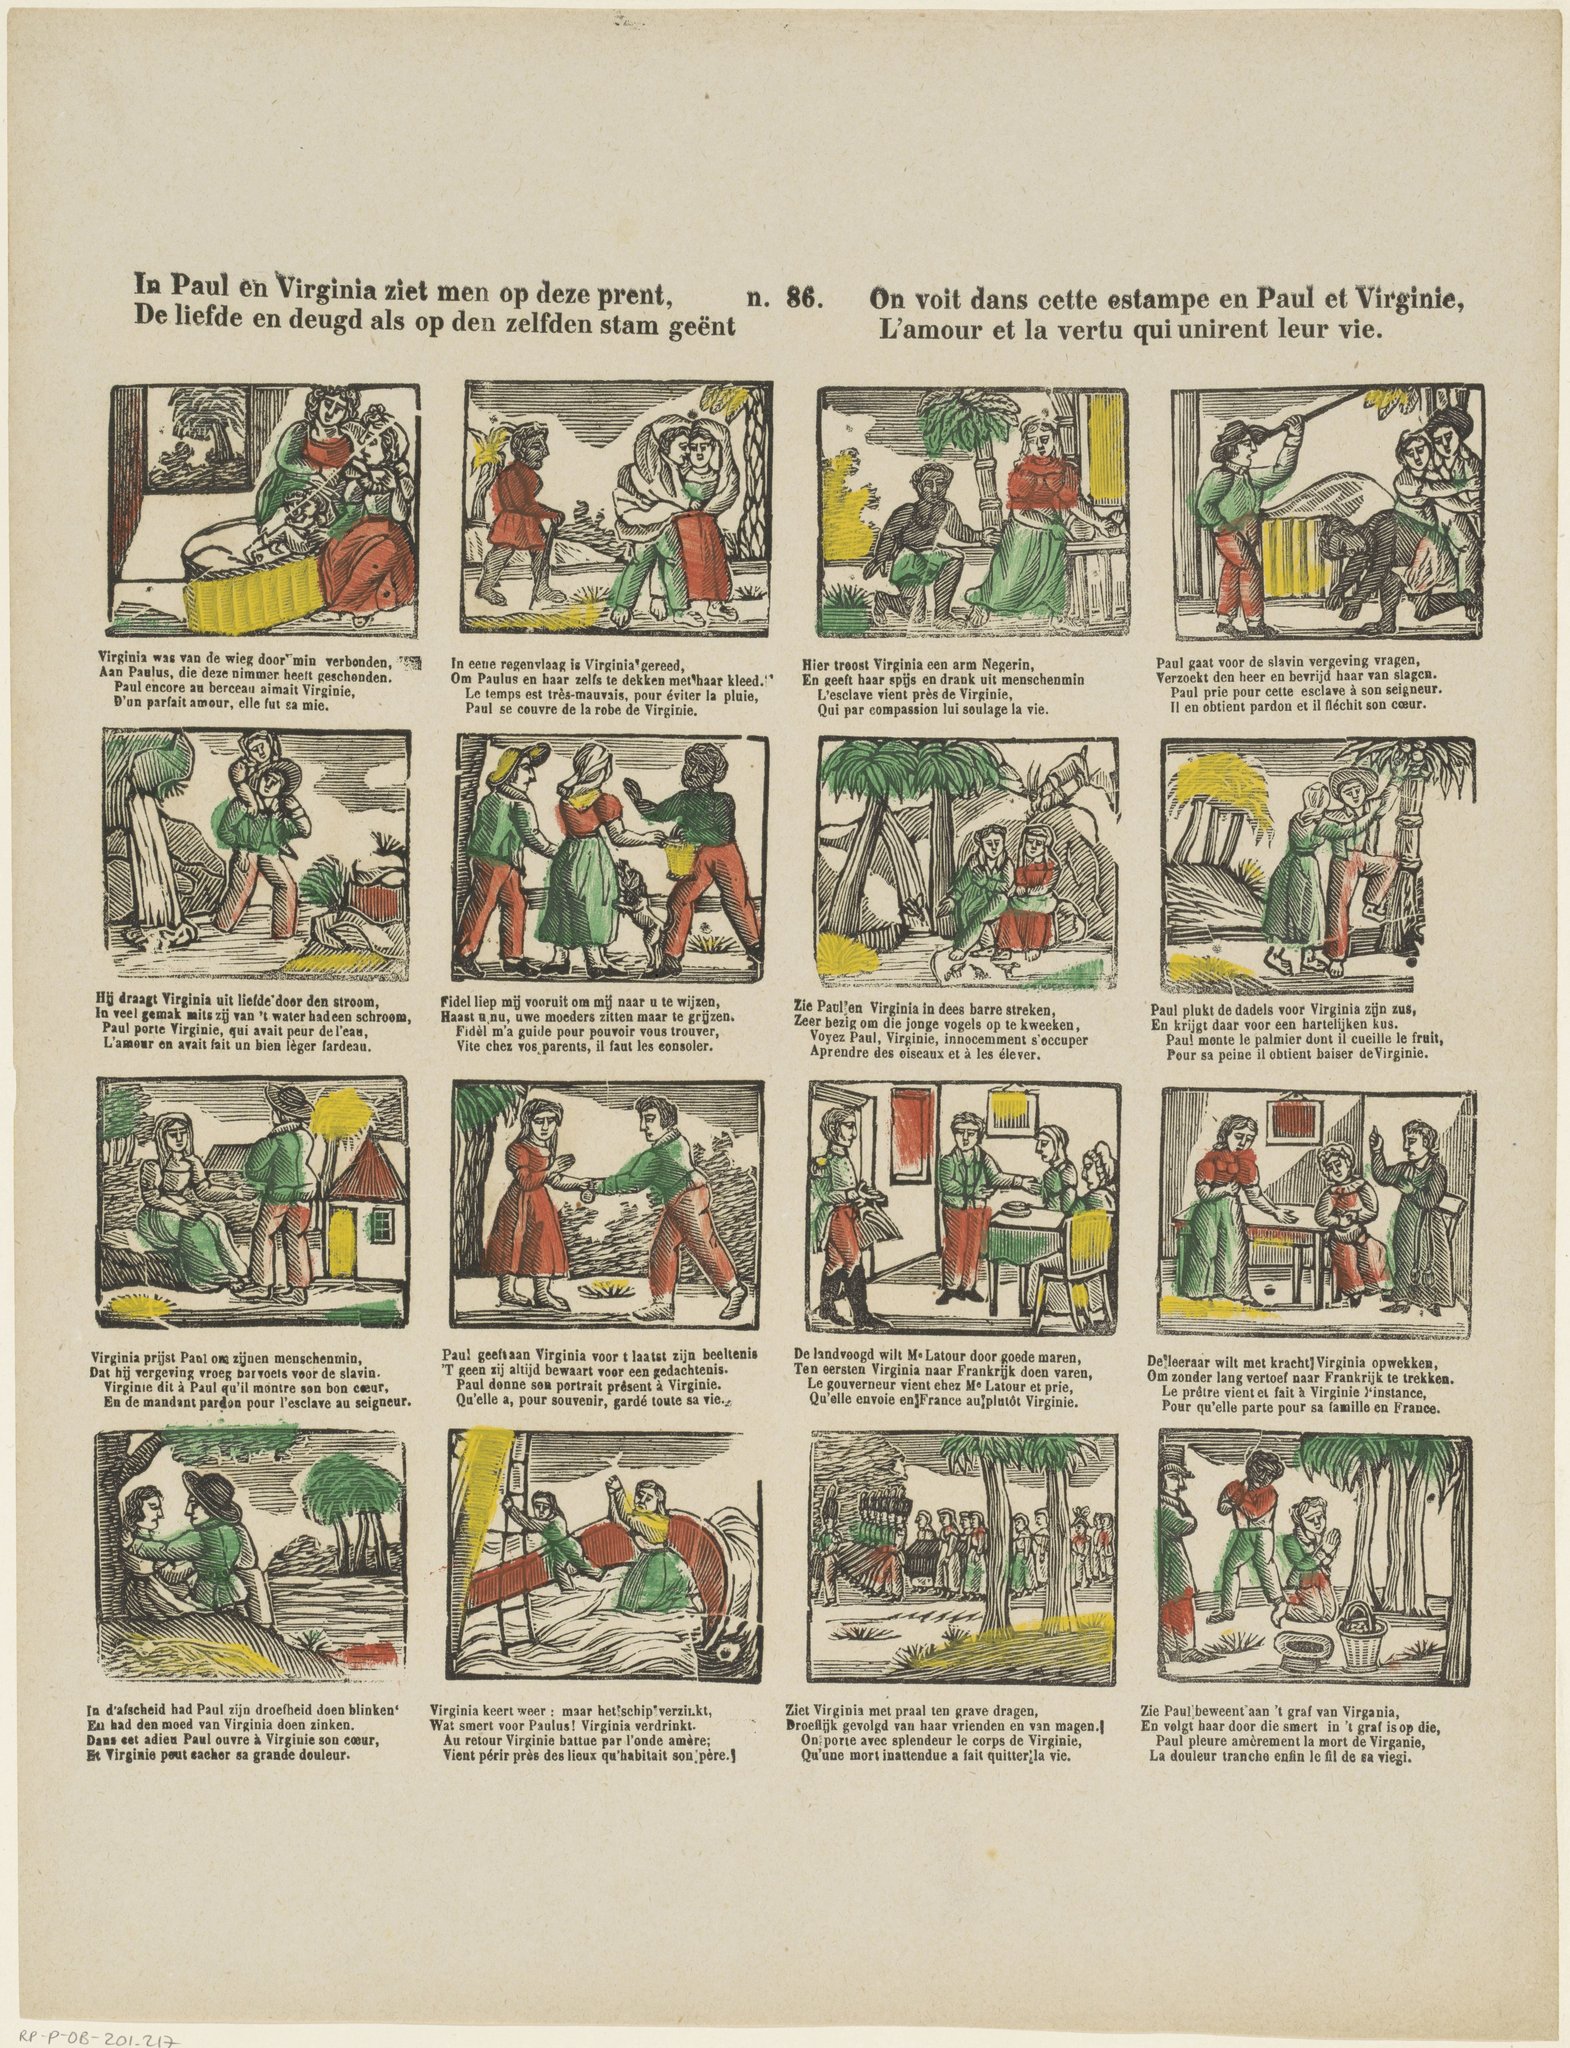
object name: print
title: In Paul en Virginia ziet men op deze prent, / De liefde en deugd als op den zelfden stam geënt / On voit dans cette estampe en Paul et Virginie, / L'amour et la vertu qui unirent leur vie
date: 1866-1902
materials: paper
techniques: colour, letterpress printing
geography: turnhout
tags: drowning, shipwrecked person, tales and fairy tales, death by drowning (non-violent)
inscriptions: collector's mark: Lugt 2760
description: Blad met 16 voorstellingen uit het verhaal van Paul en Virginia. Virginia verdrinkt. Onder elke voorstelling een tweeregelig vers in het Nederlands en in het Frans. Genummerd midden boven: n. 86.